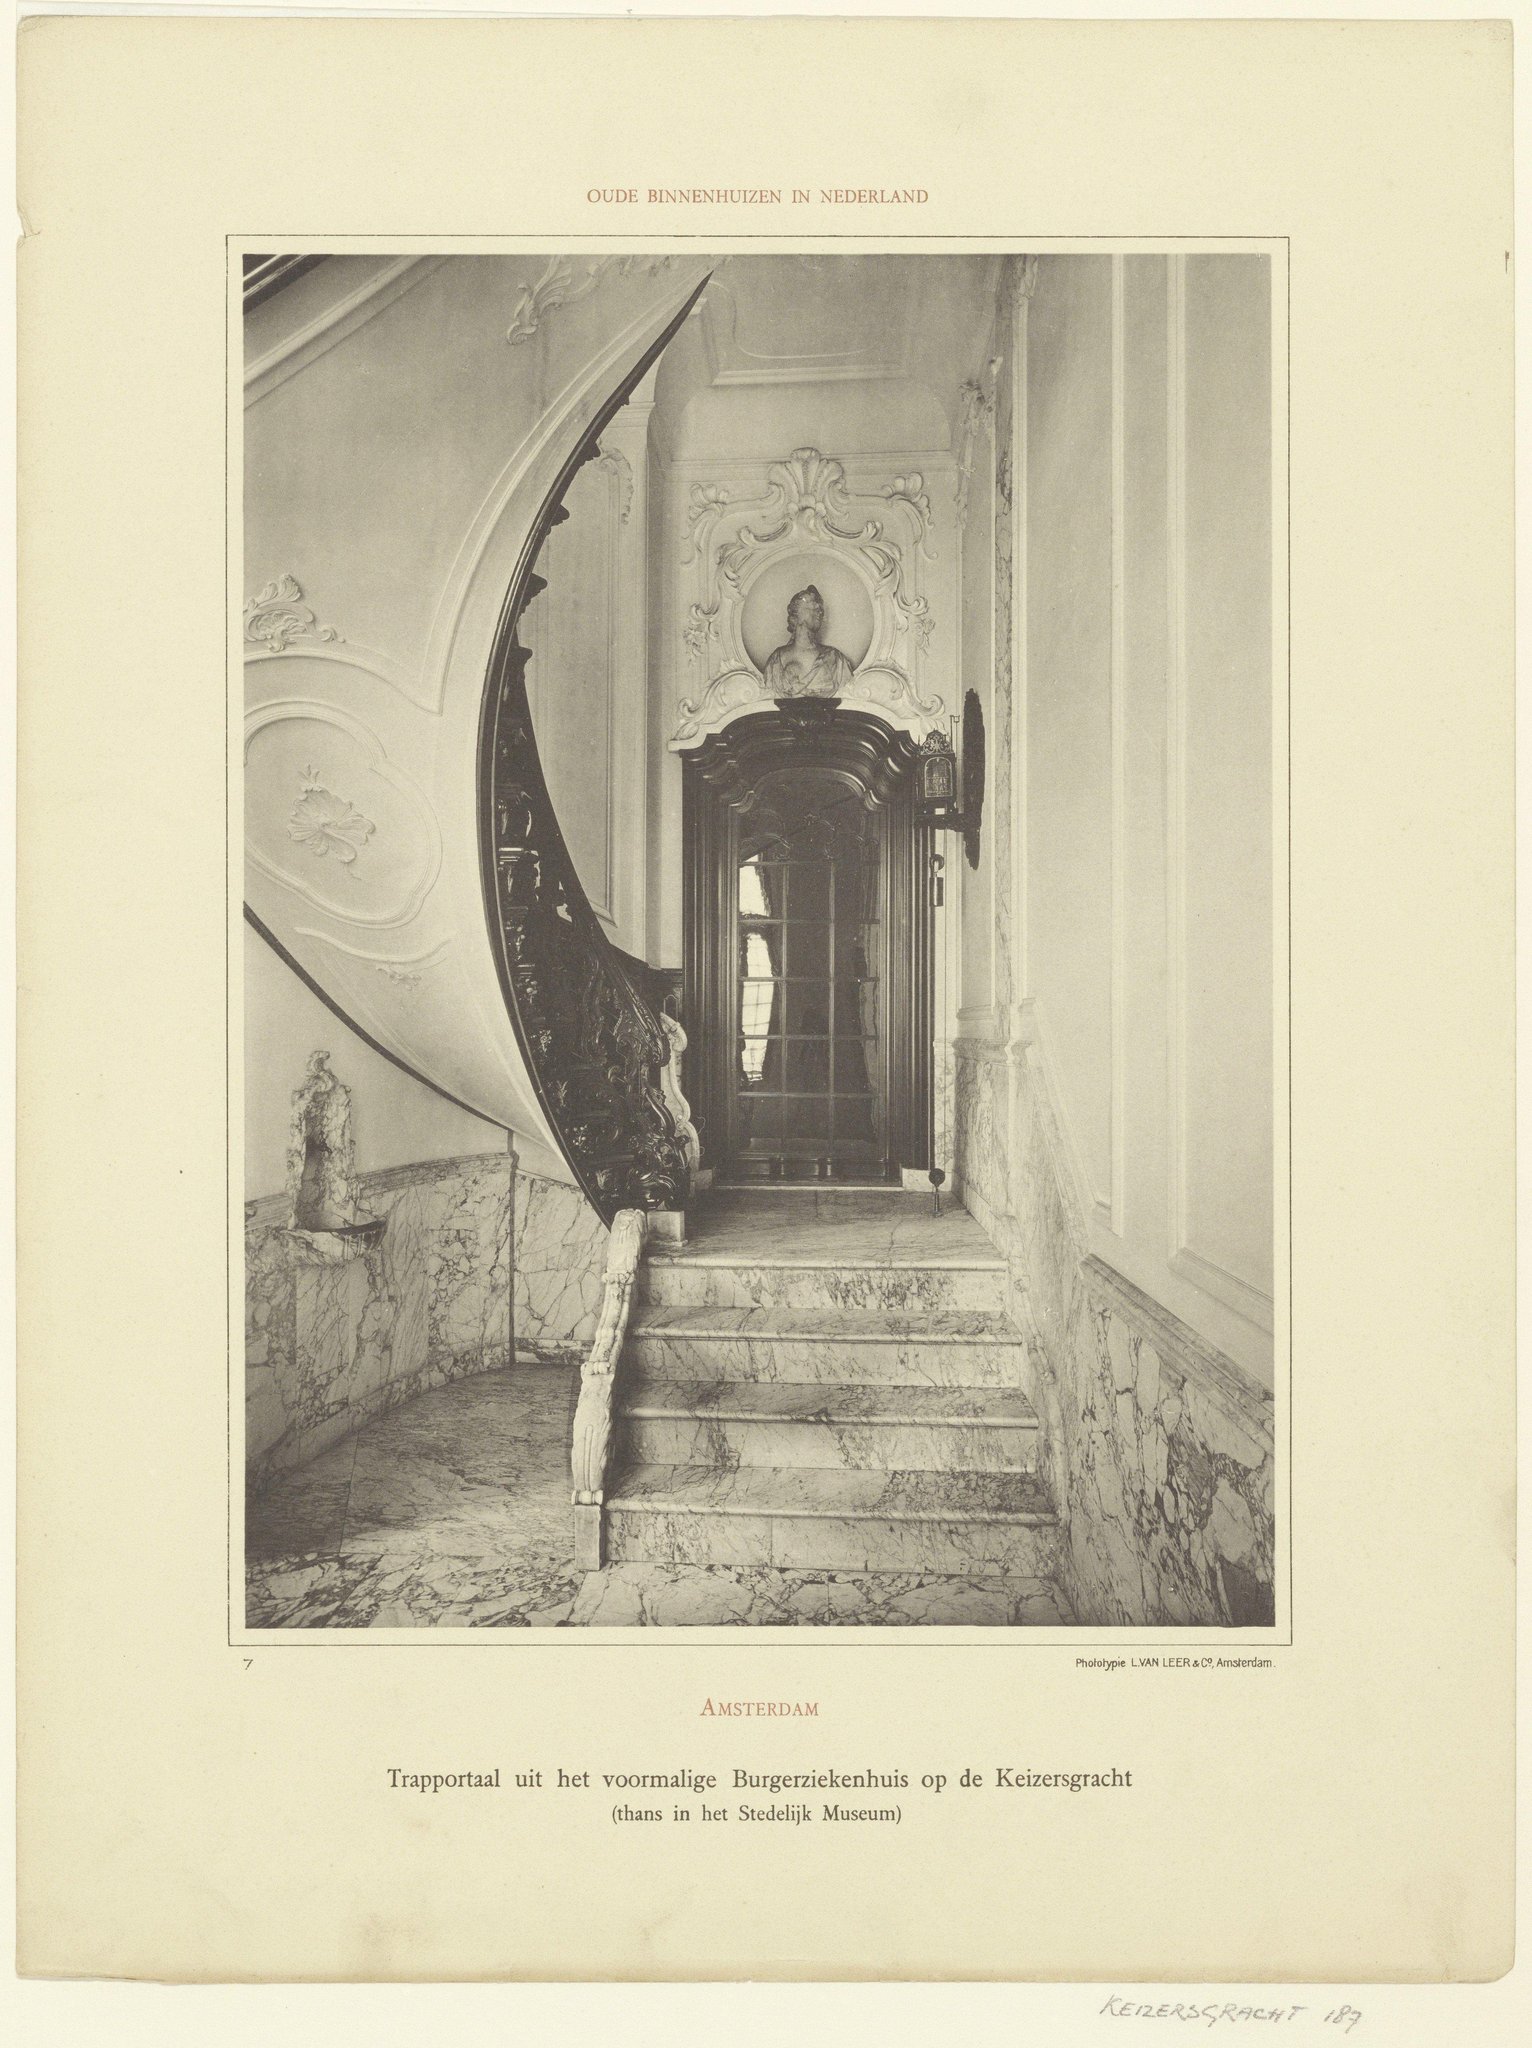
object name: architectural element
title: Onderdelen van het trapportaal uit het pand aan de Keizersgracht 187 te Amsterdam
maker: Anonymous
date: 1740-1760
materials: wood, marble